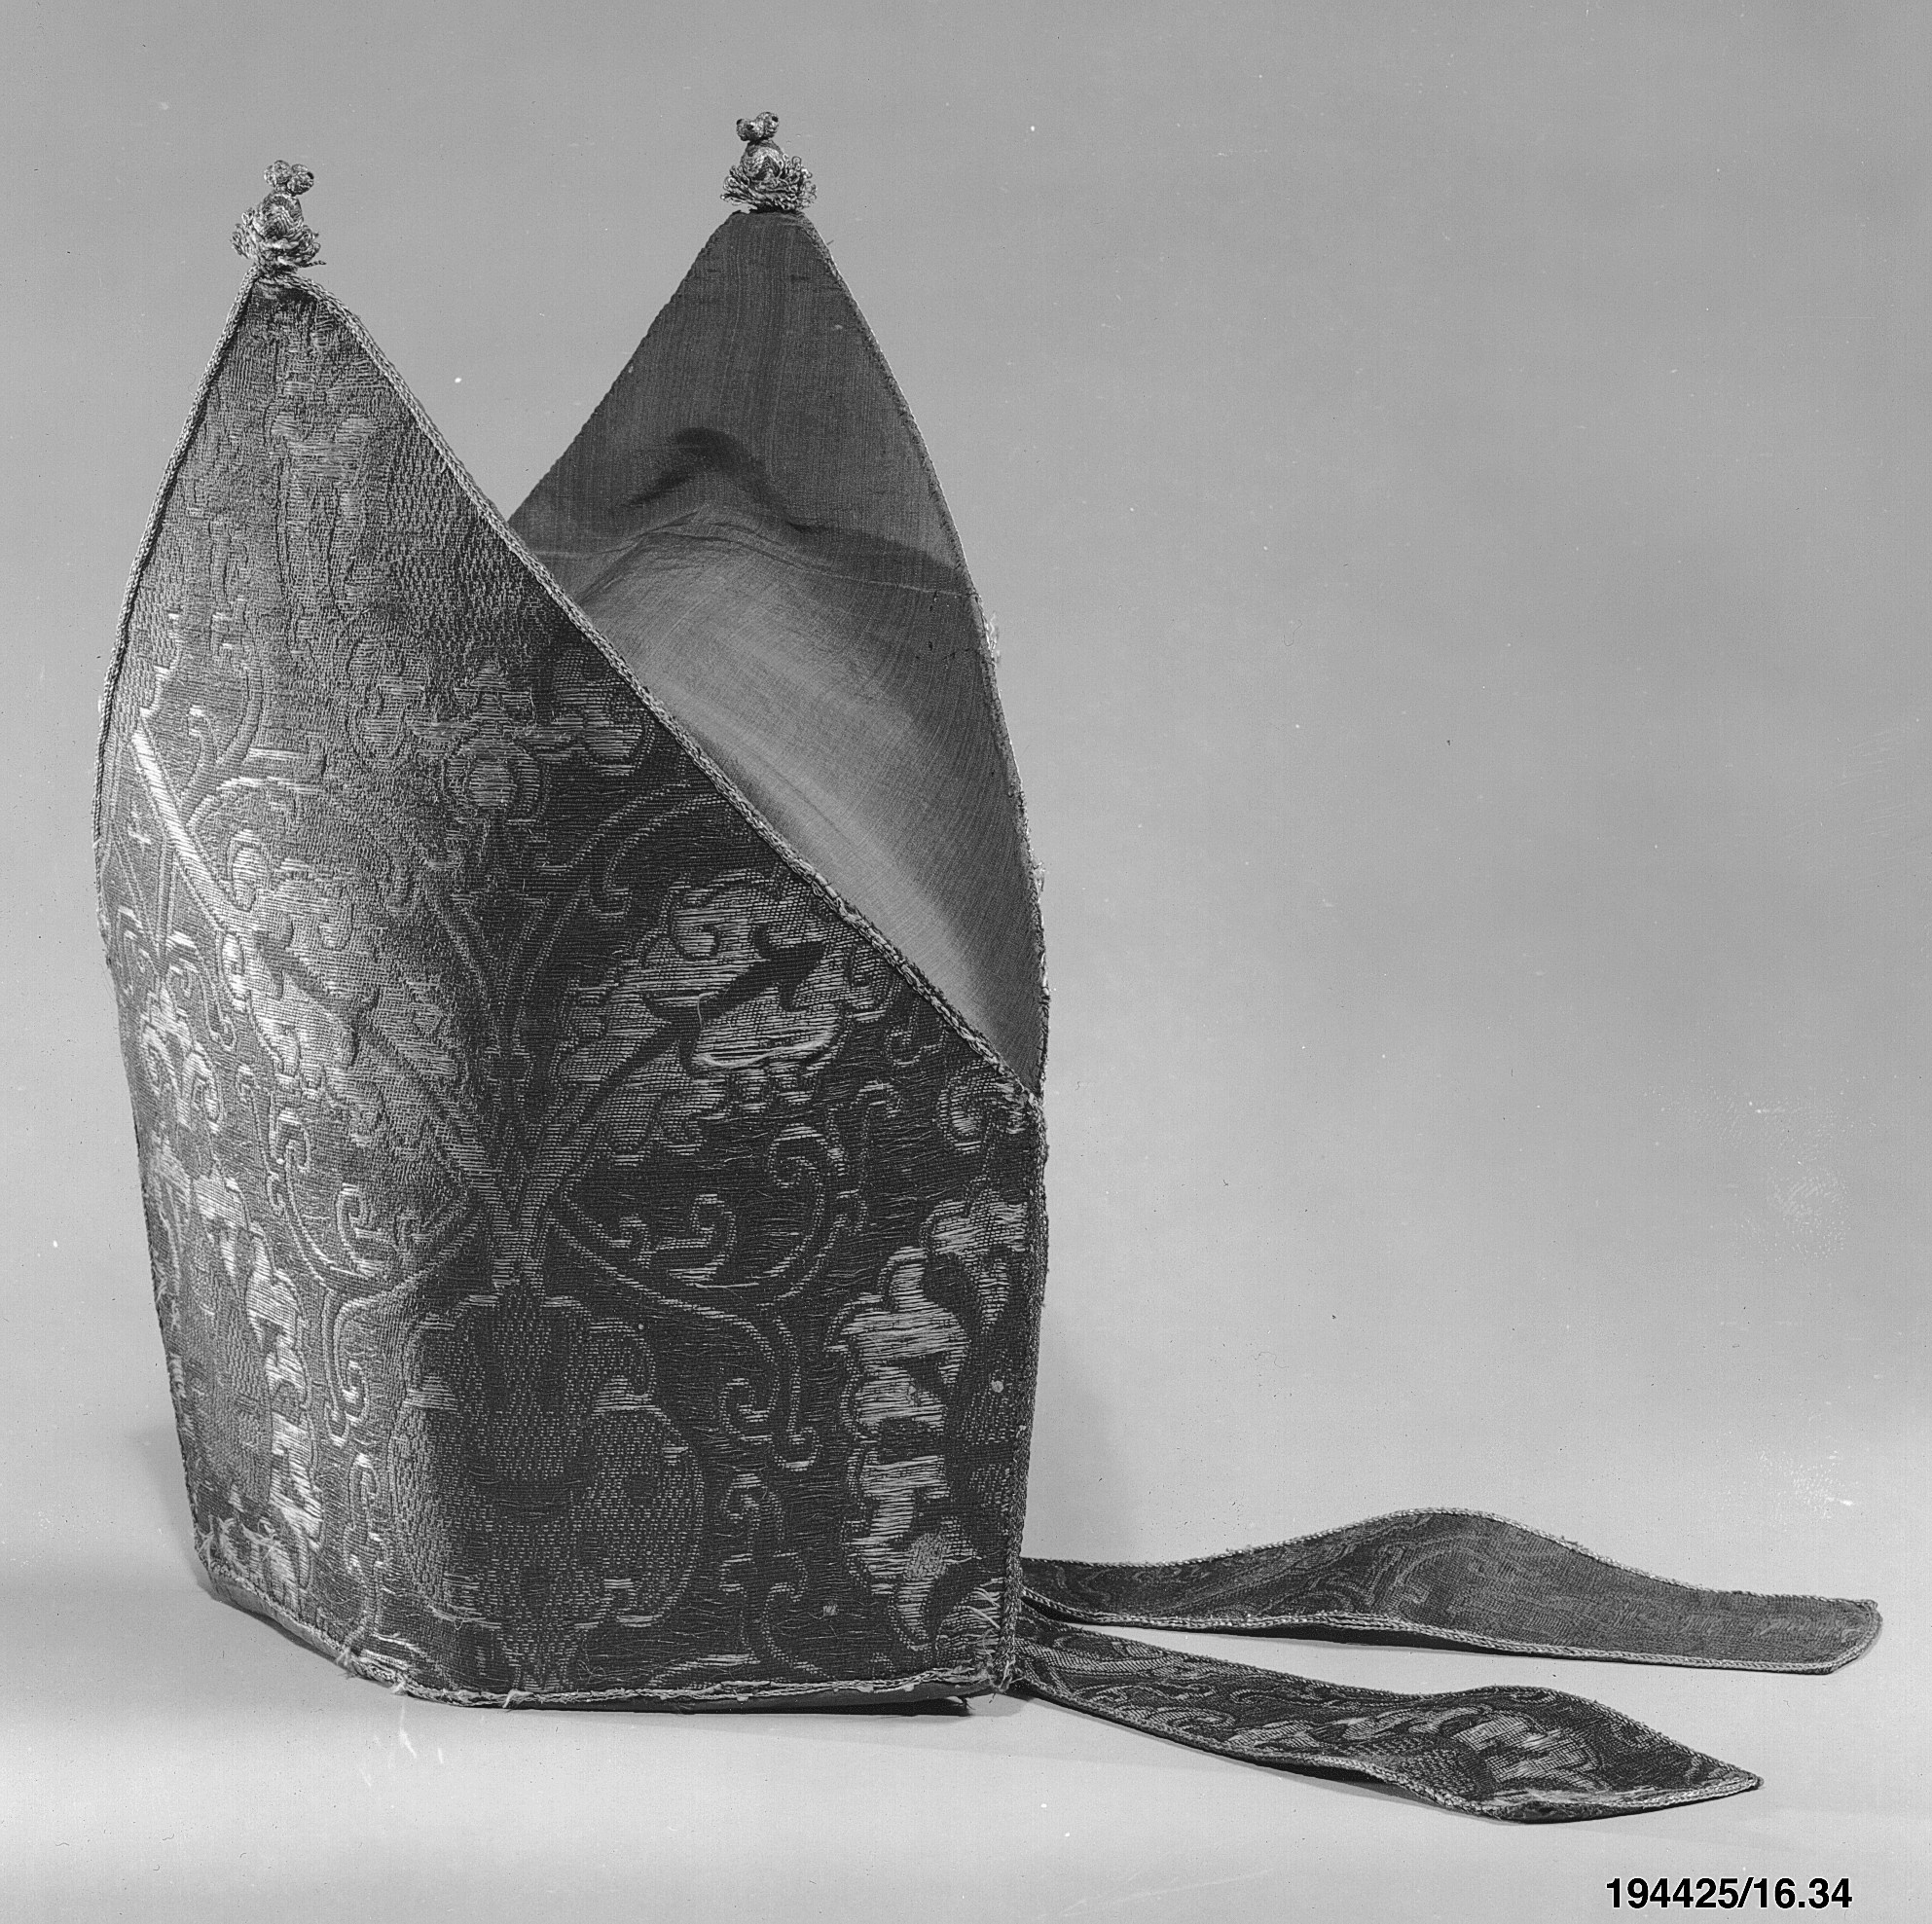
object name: mitre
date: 1501-1600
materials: metal thread, silk